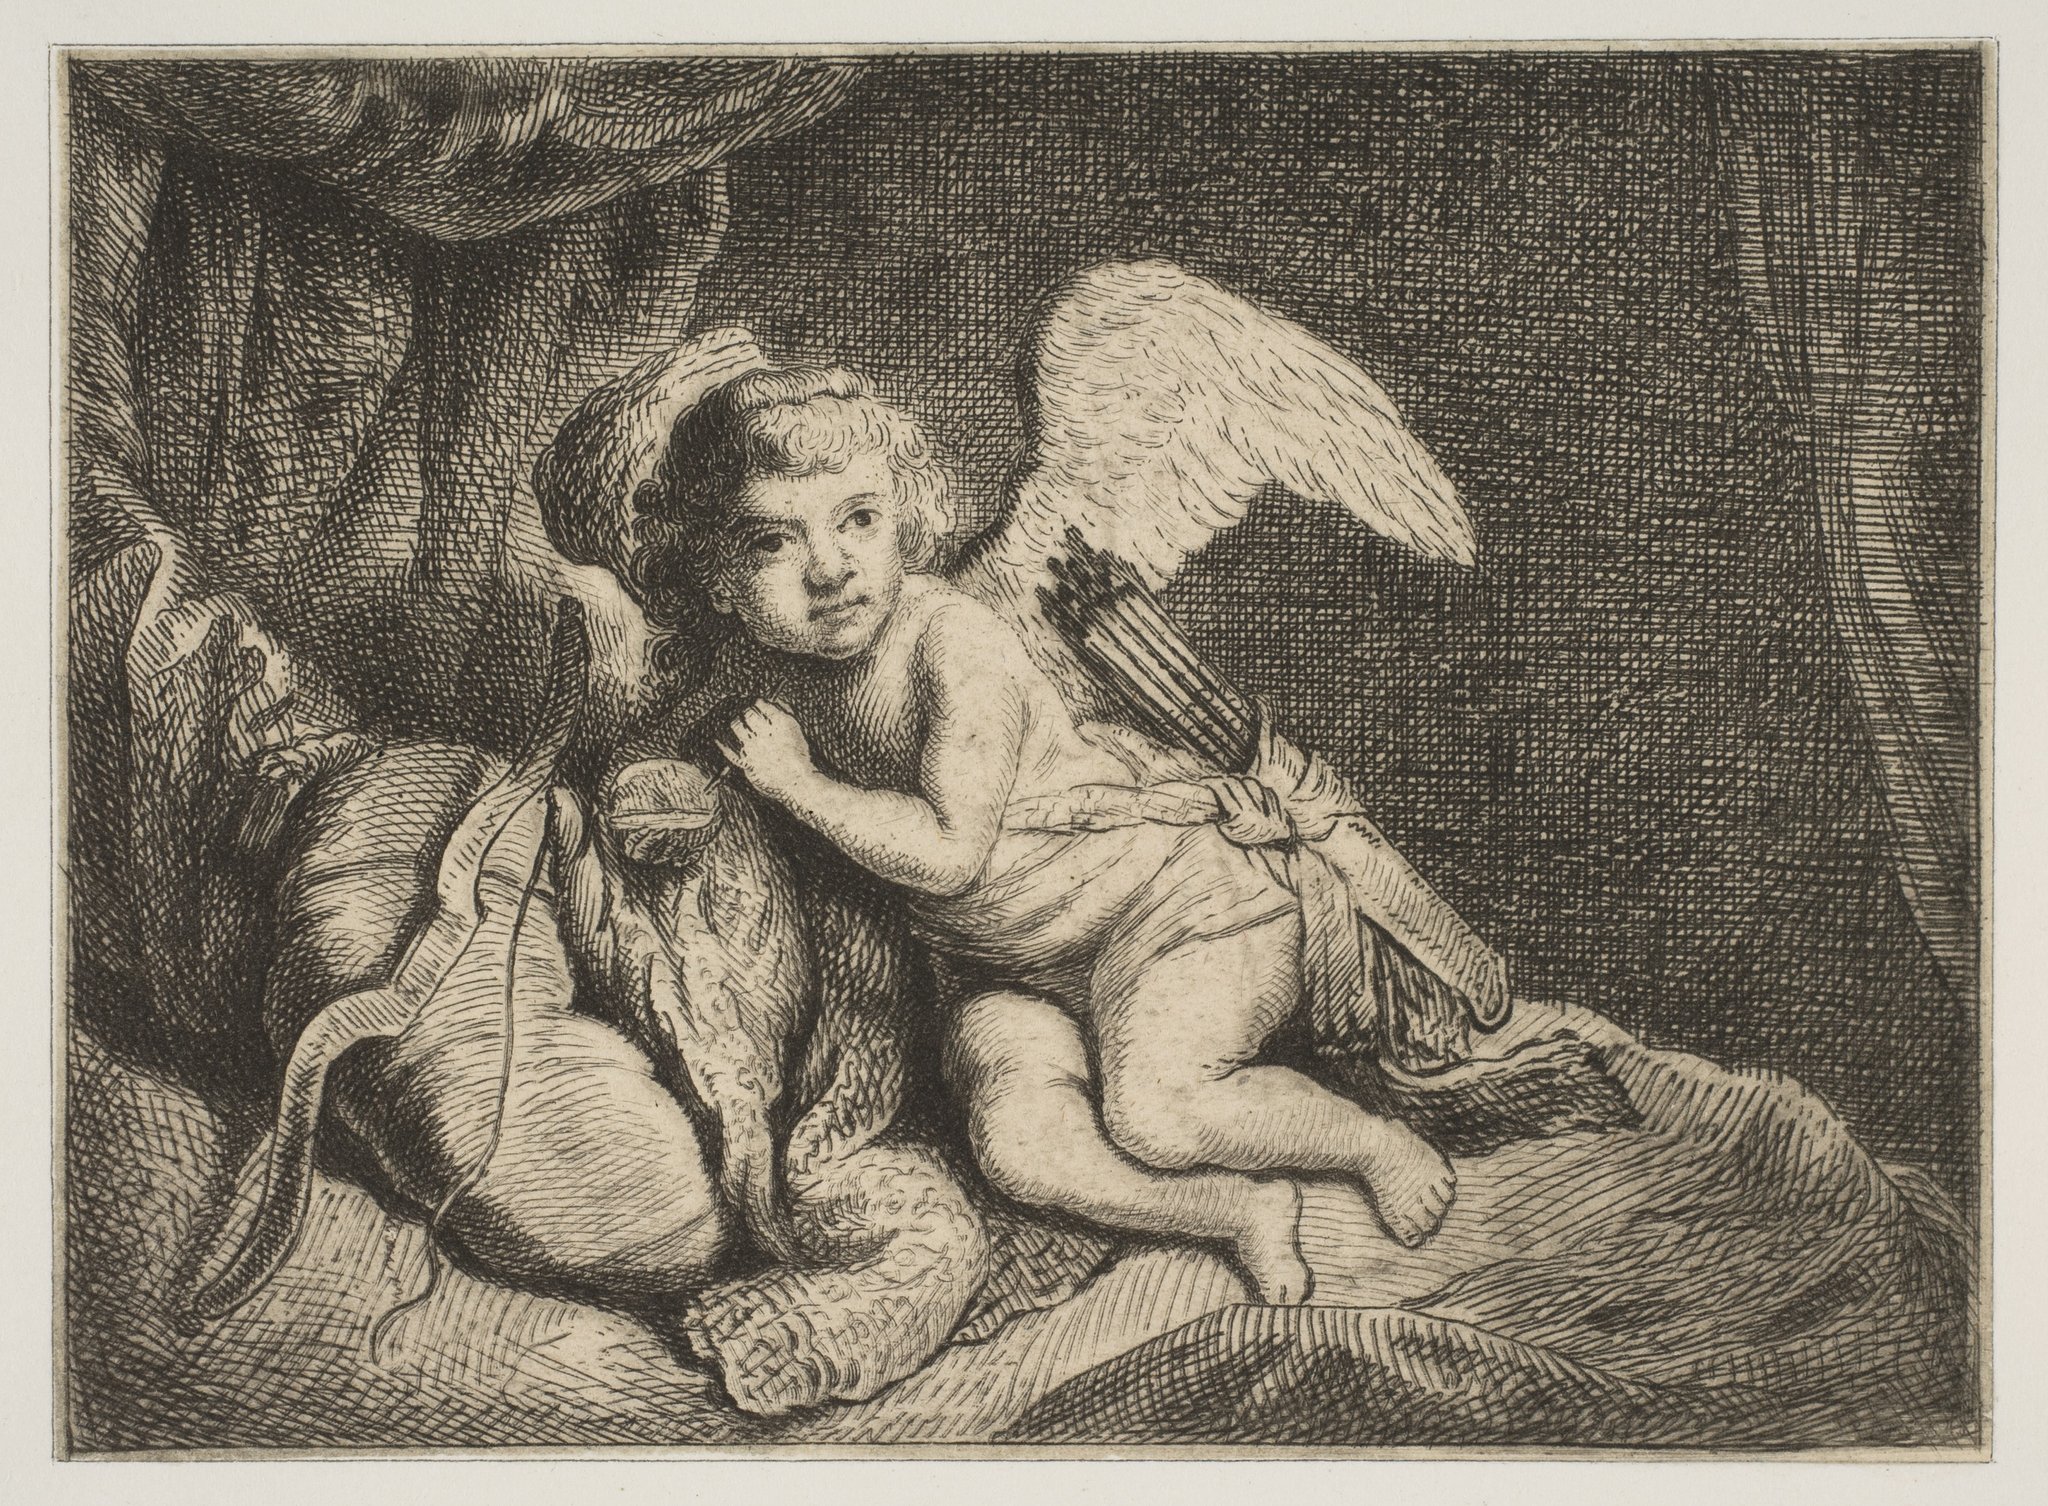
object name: print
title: Cupid Resting (copy)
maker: rembrandt (rembrandt van rijn)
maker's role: former attribution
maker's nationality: dutch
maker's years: 1606-1669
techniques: drypoint, etching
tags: cupid